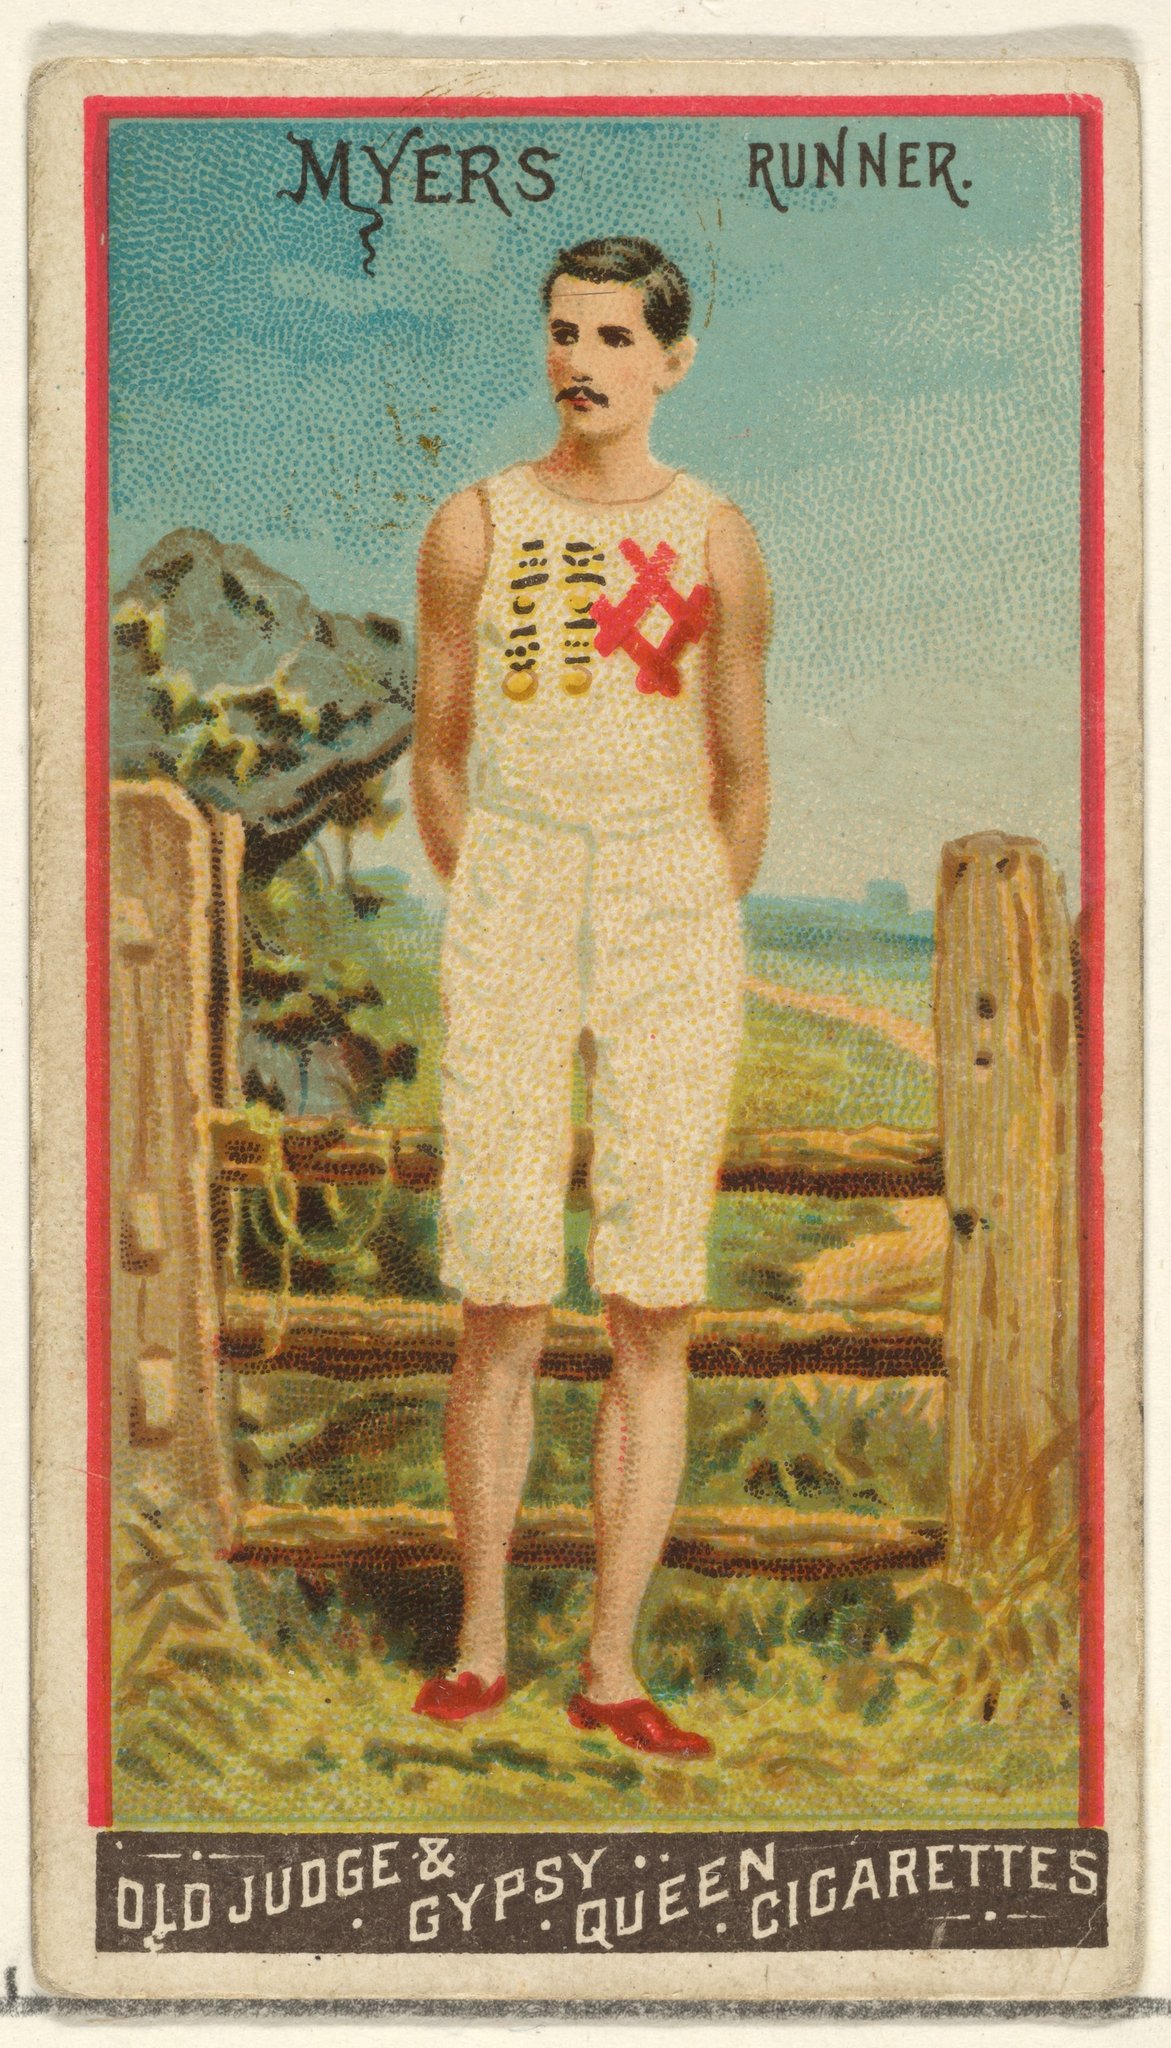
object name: print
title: Myers, Runner, from the Goodwin Champion series for Old Judge and Gypsy Queen Cigarettes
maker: goodwin & company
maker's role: publisher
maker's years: 1850-1950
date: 1888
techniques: color lithograph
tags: men,portraits,athletes